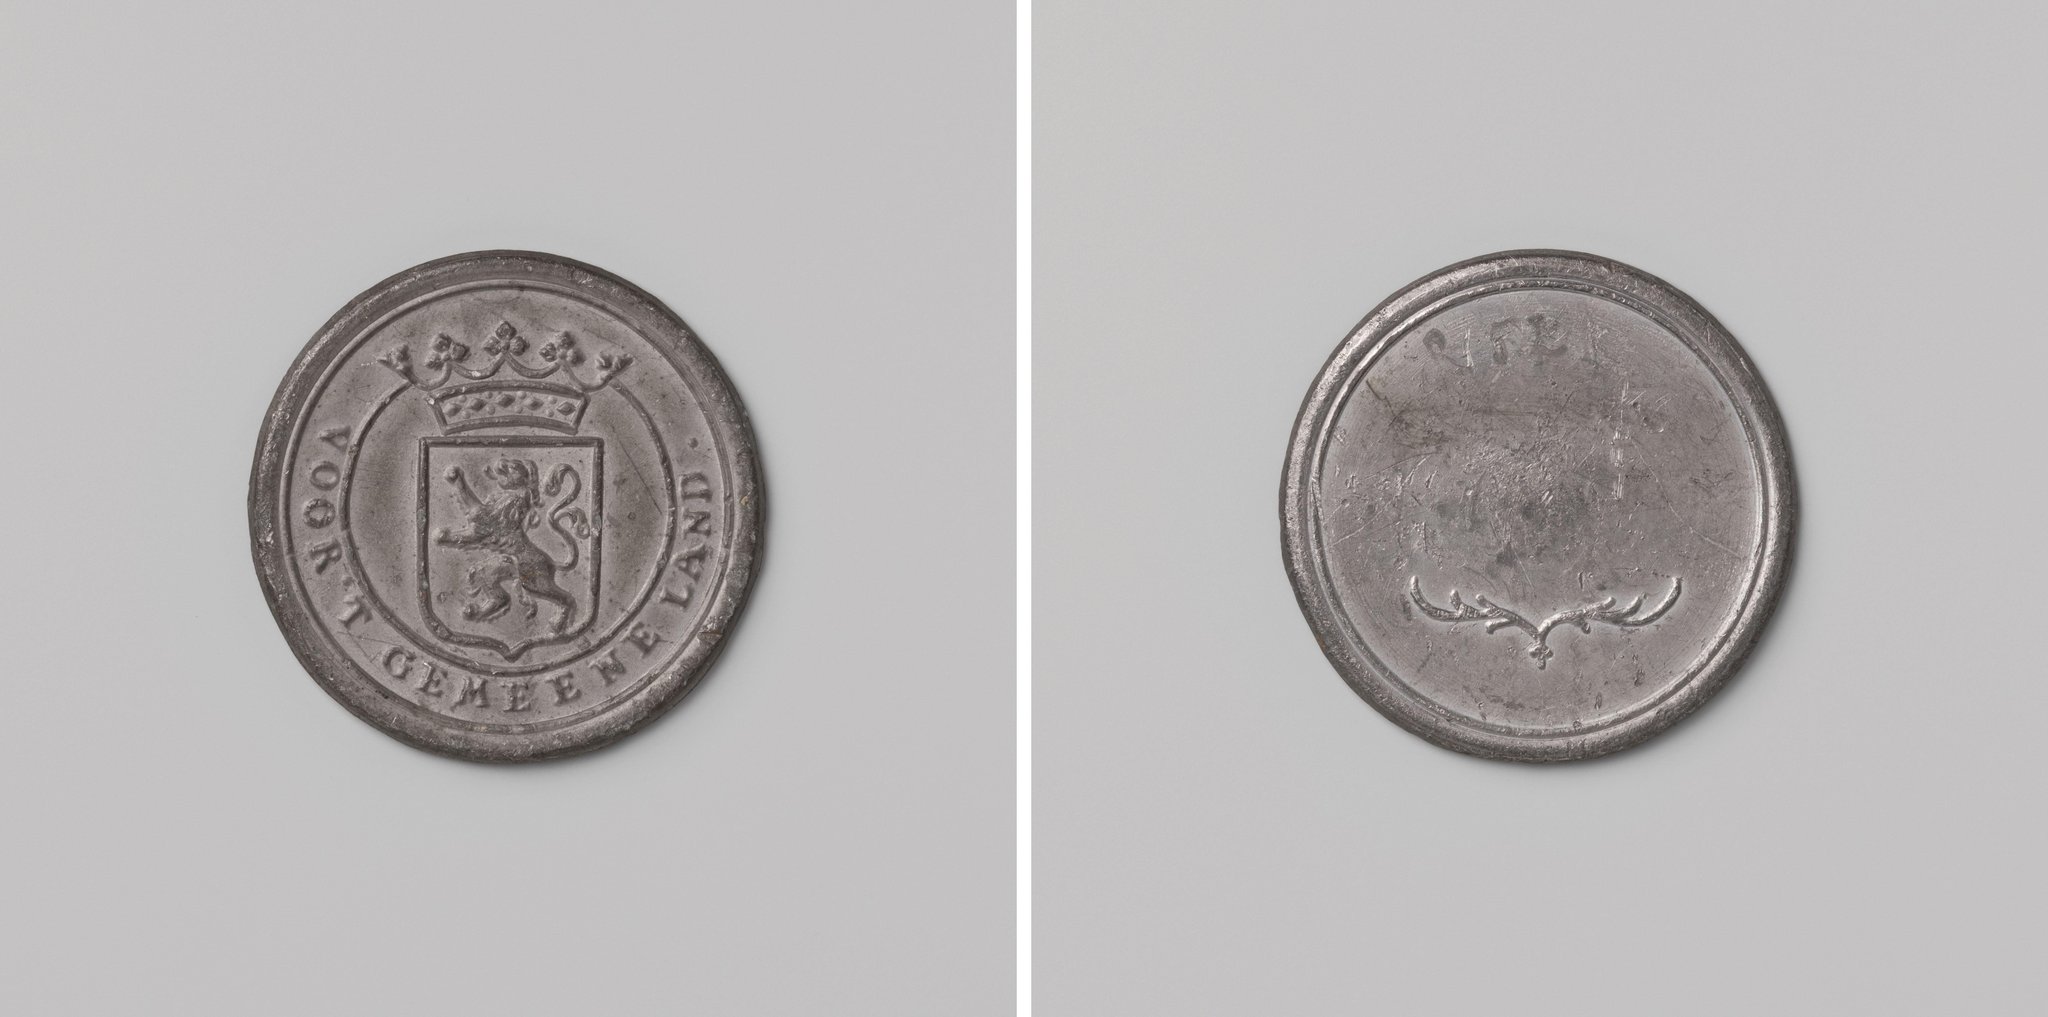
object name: medal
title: Penning met wapen van Holland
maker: Anonymous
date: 1885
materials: lead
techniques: striking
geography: netherlands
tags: coat of arms (as symbol of the state, etc.) (+ province; provincial), holland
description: Penning van lood: Voorzijde: gekroond wapenschild binnen omschrift. Keerzijde: blanco veld boven twee gekruiste takken